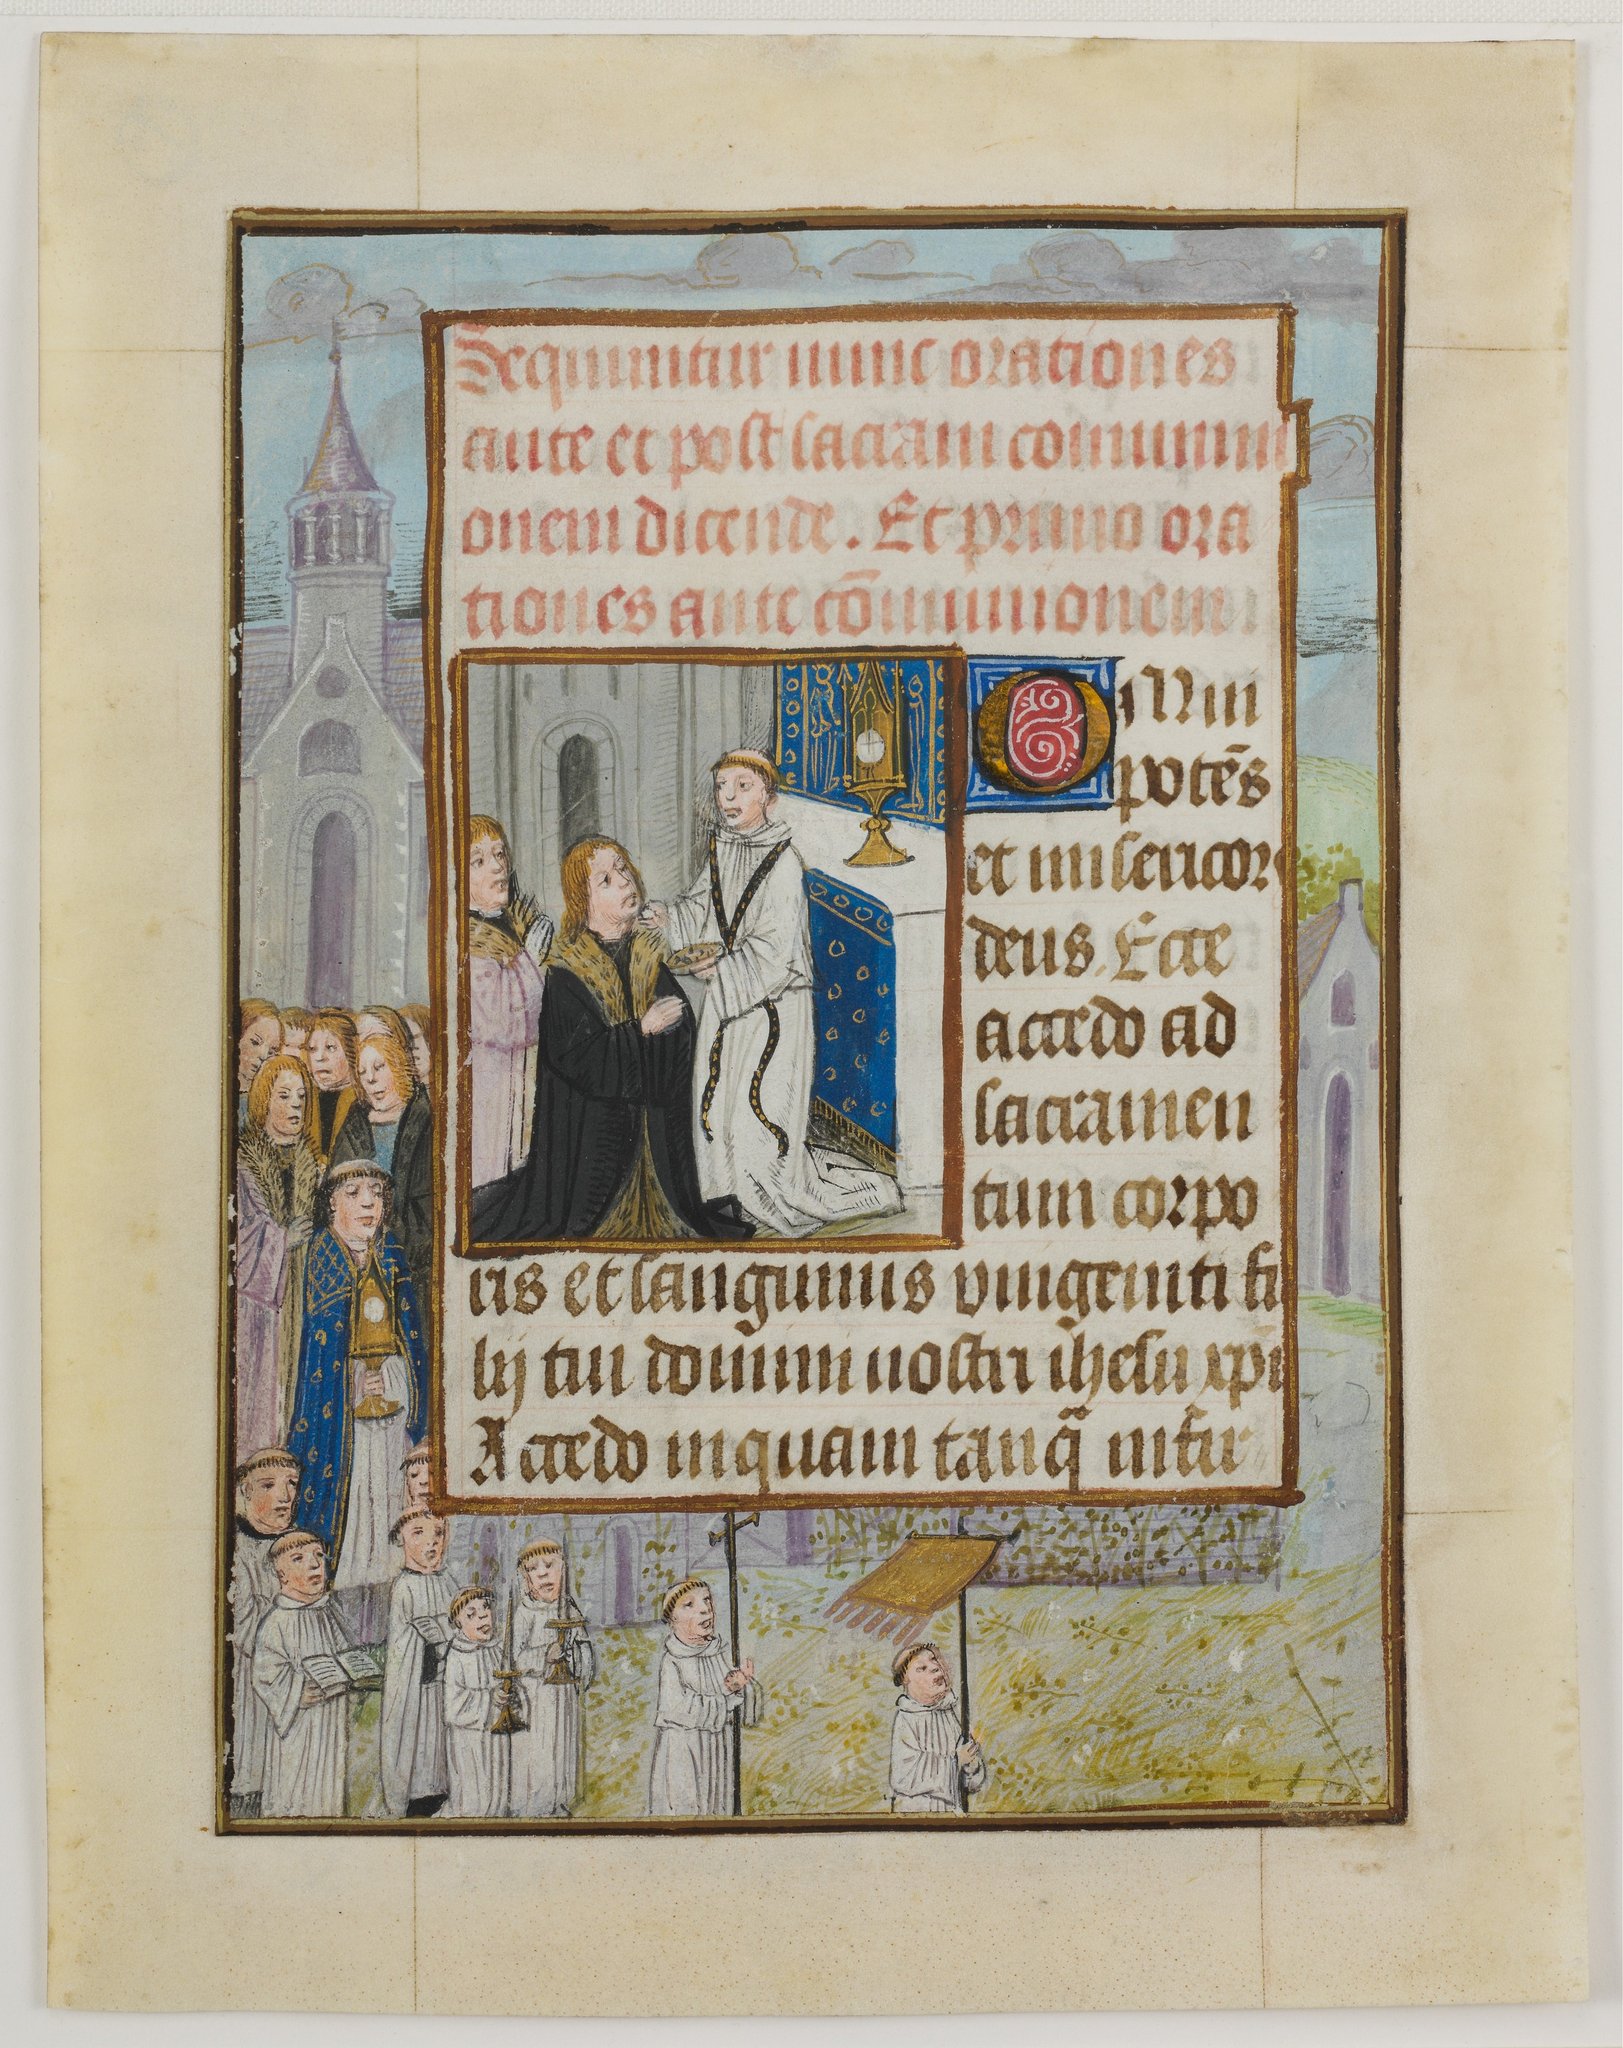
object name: book of hour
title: Manuscript Leaf with the Holy Communion, from a Book of Hours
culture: dutch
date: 1500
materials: gold, ink, parchment, shell, paint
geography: netherlands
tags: saints